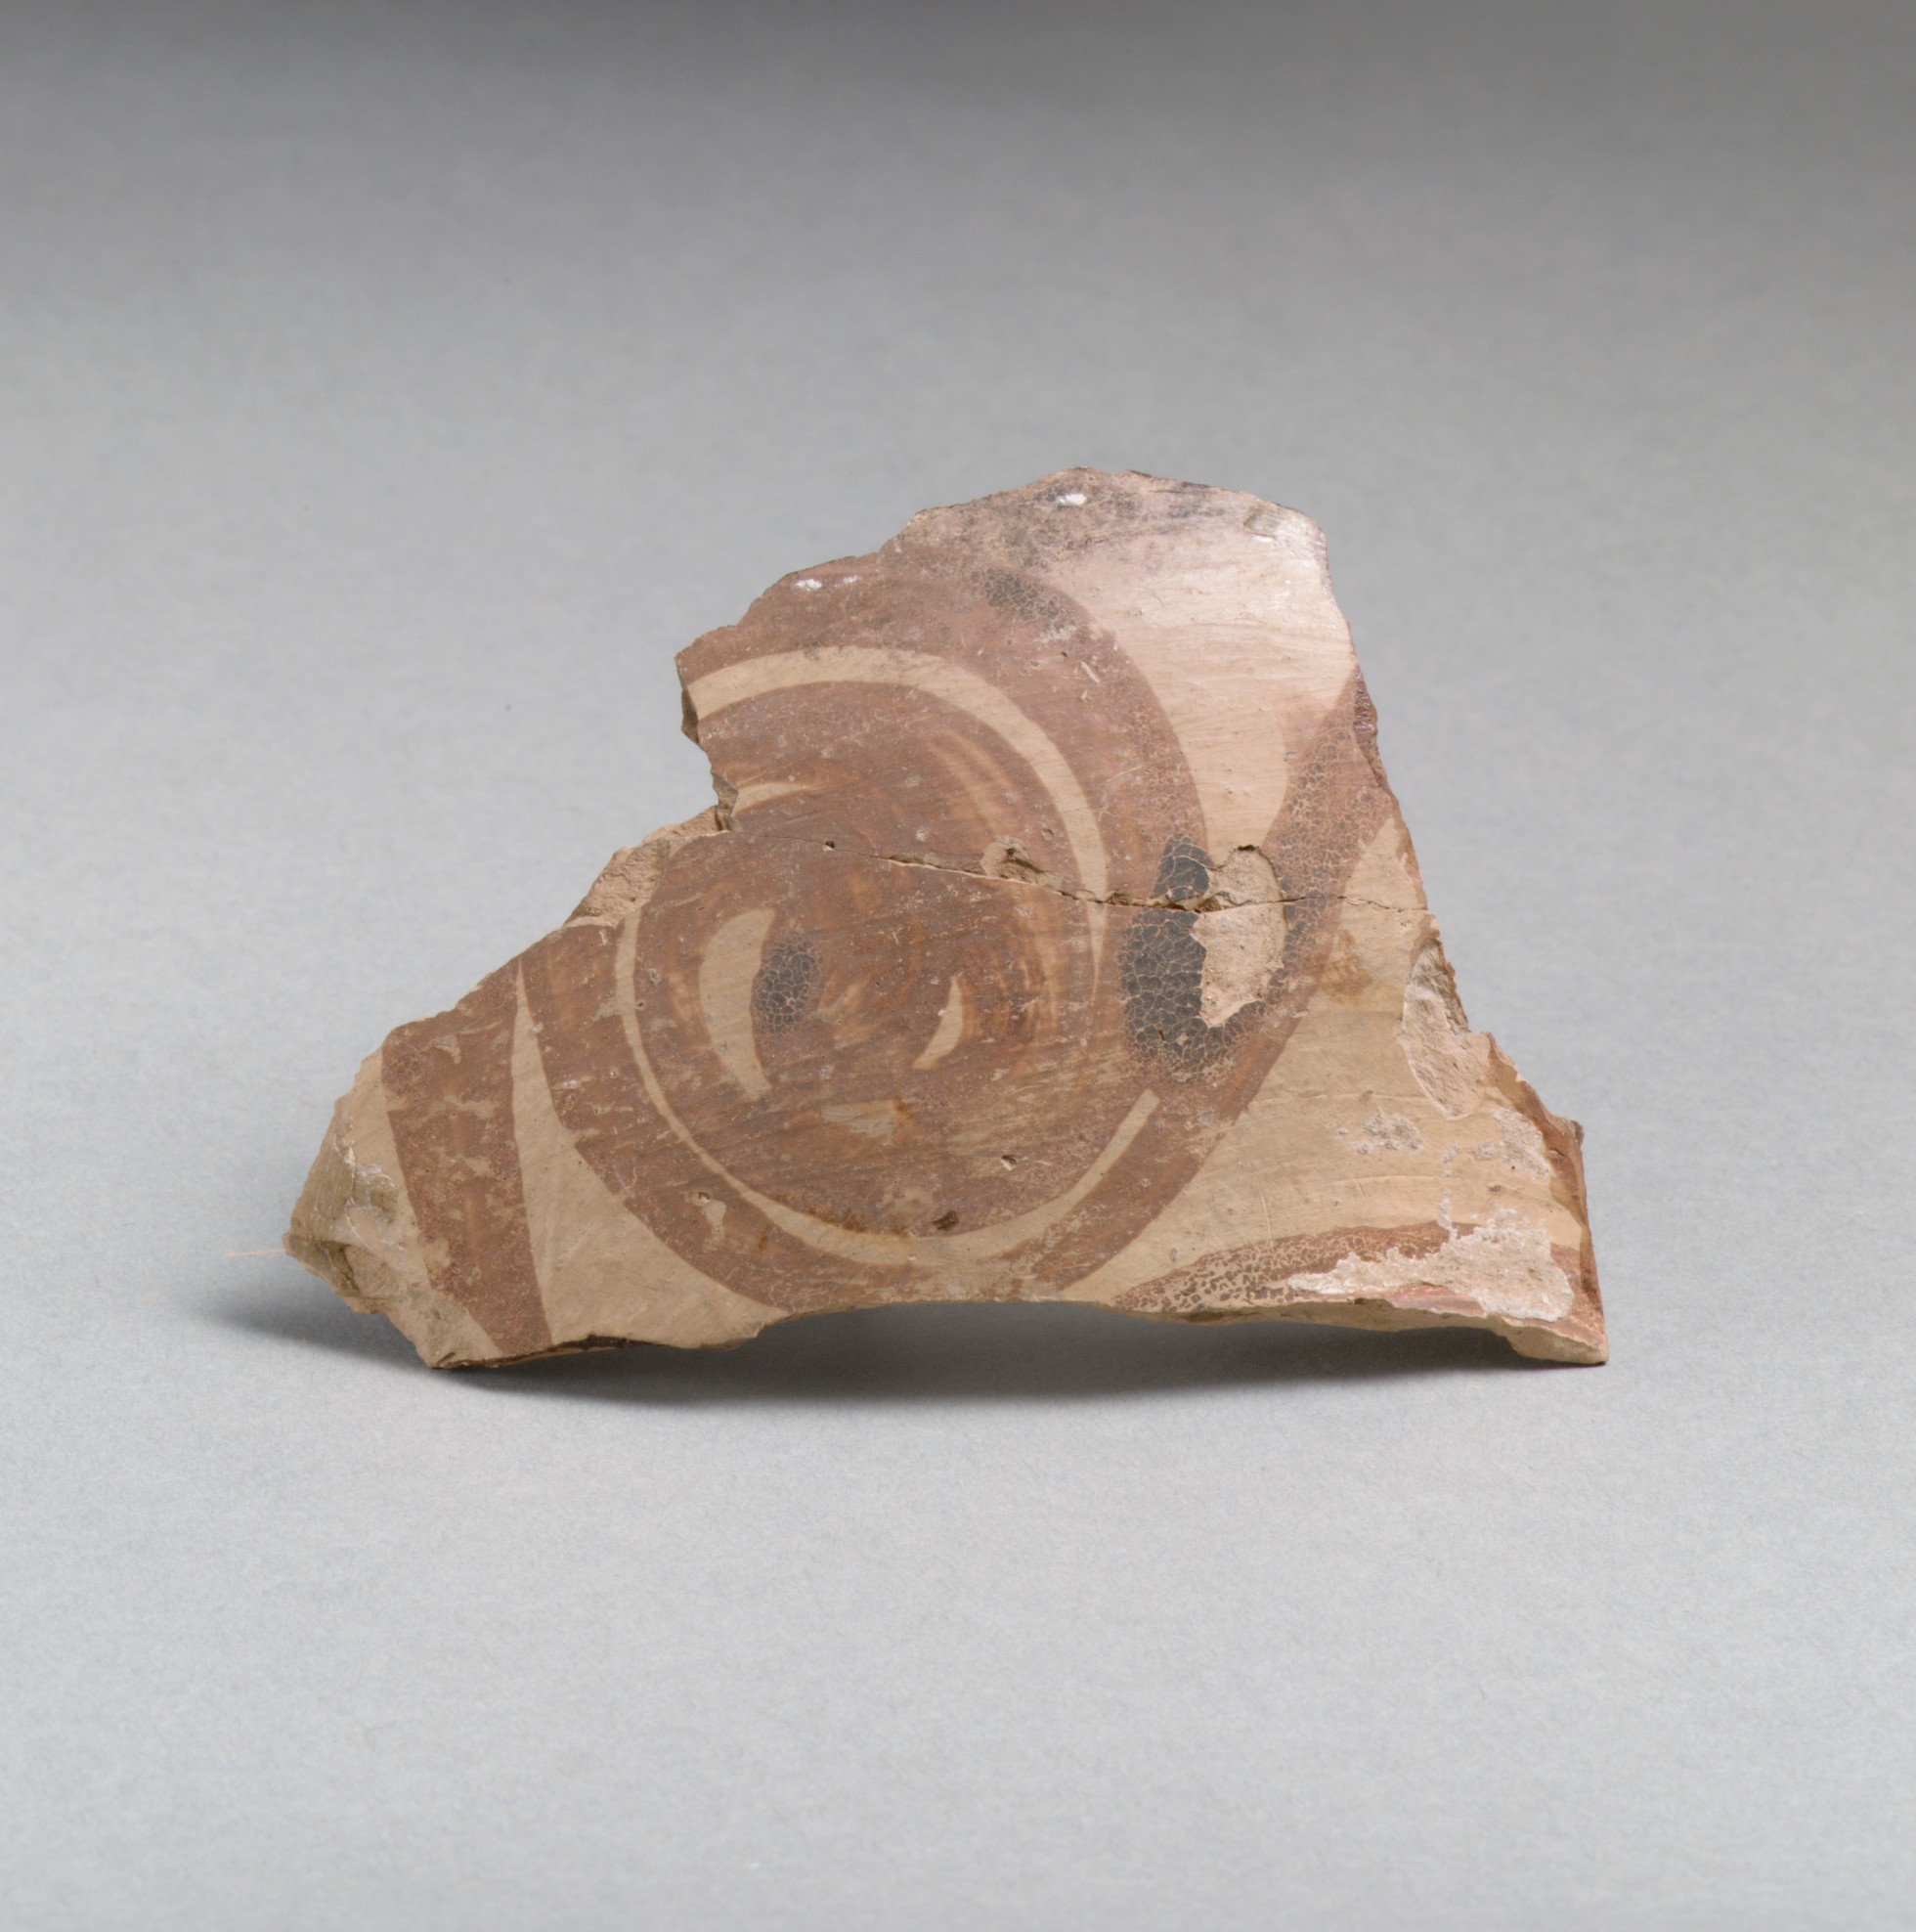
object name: vase fragment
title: Vase fragments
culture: minoan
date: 1600-1450 BCE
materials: terracotta